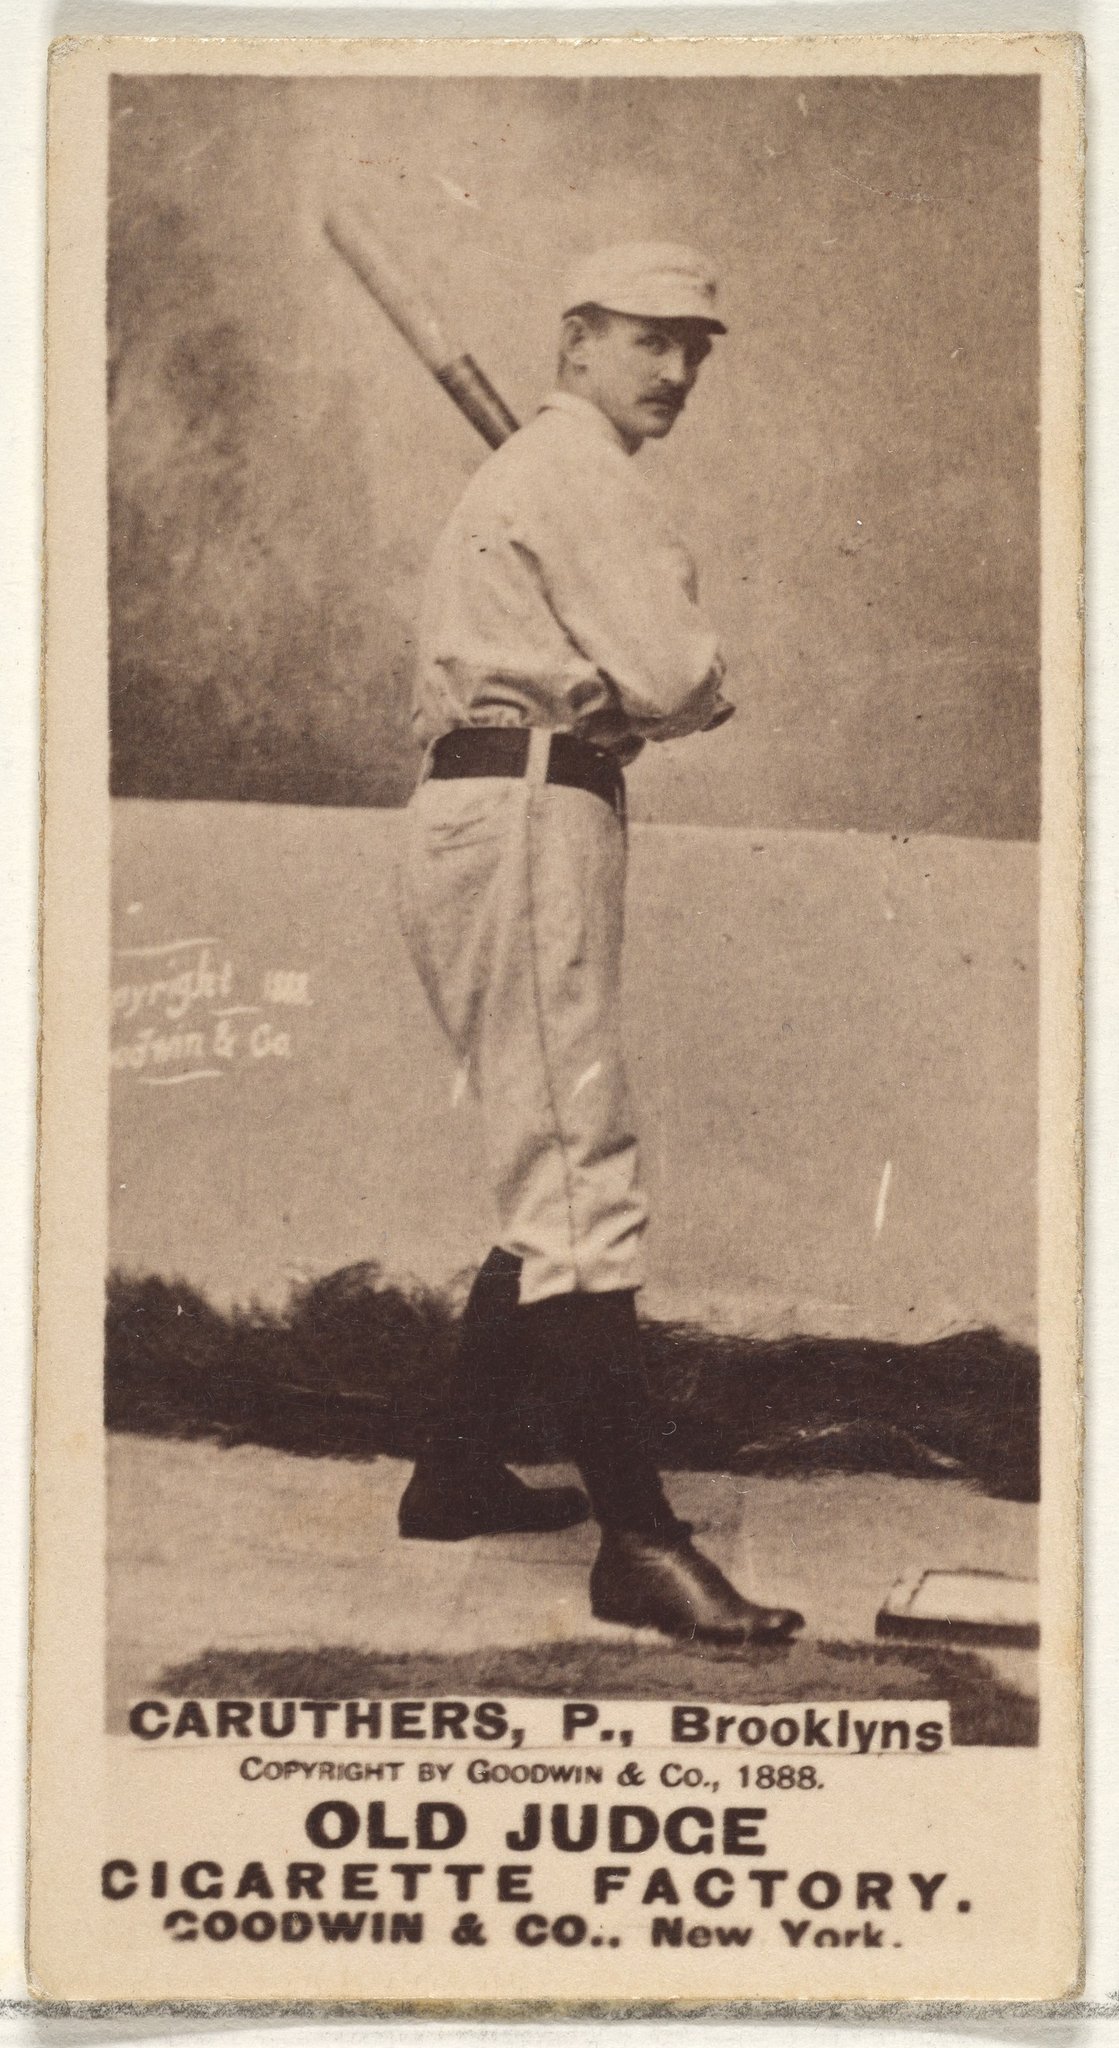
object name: baseball card, photograph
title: Caruthers, Pitcher, Brooklyn, from the Old Judge series (N172) for Old Judge Cigarettes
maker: goodwin & company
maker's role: publisher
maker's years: 1850-1950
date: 1888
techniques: albumen silver print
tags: men,portraits,baseball,athletes